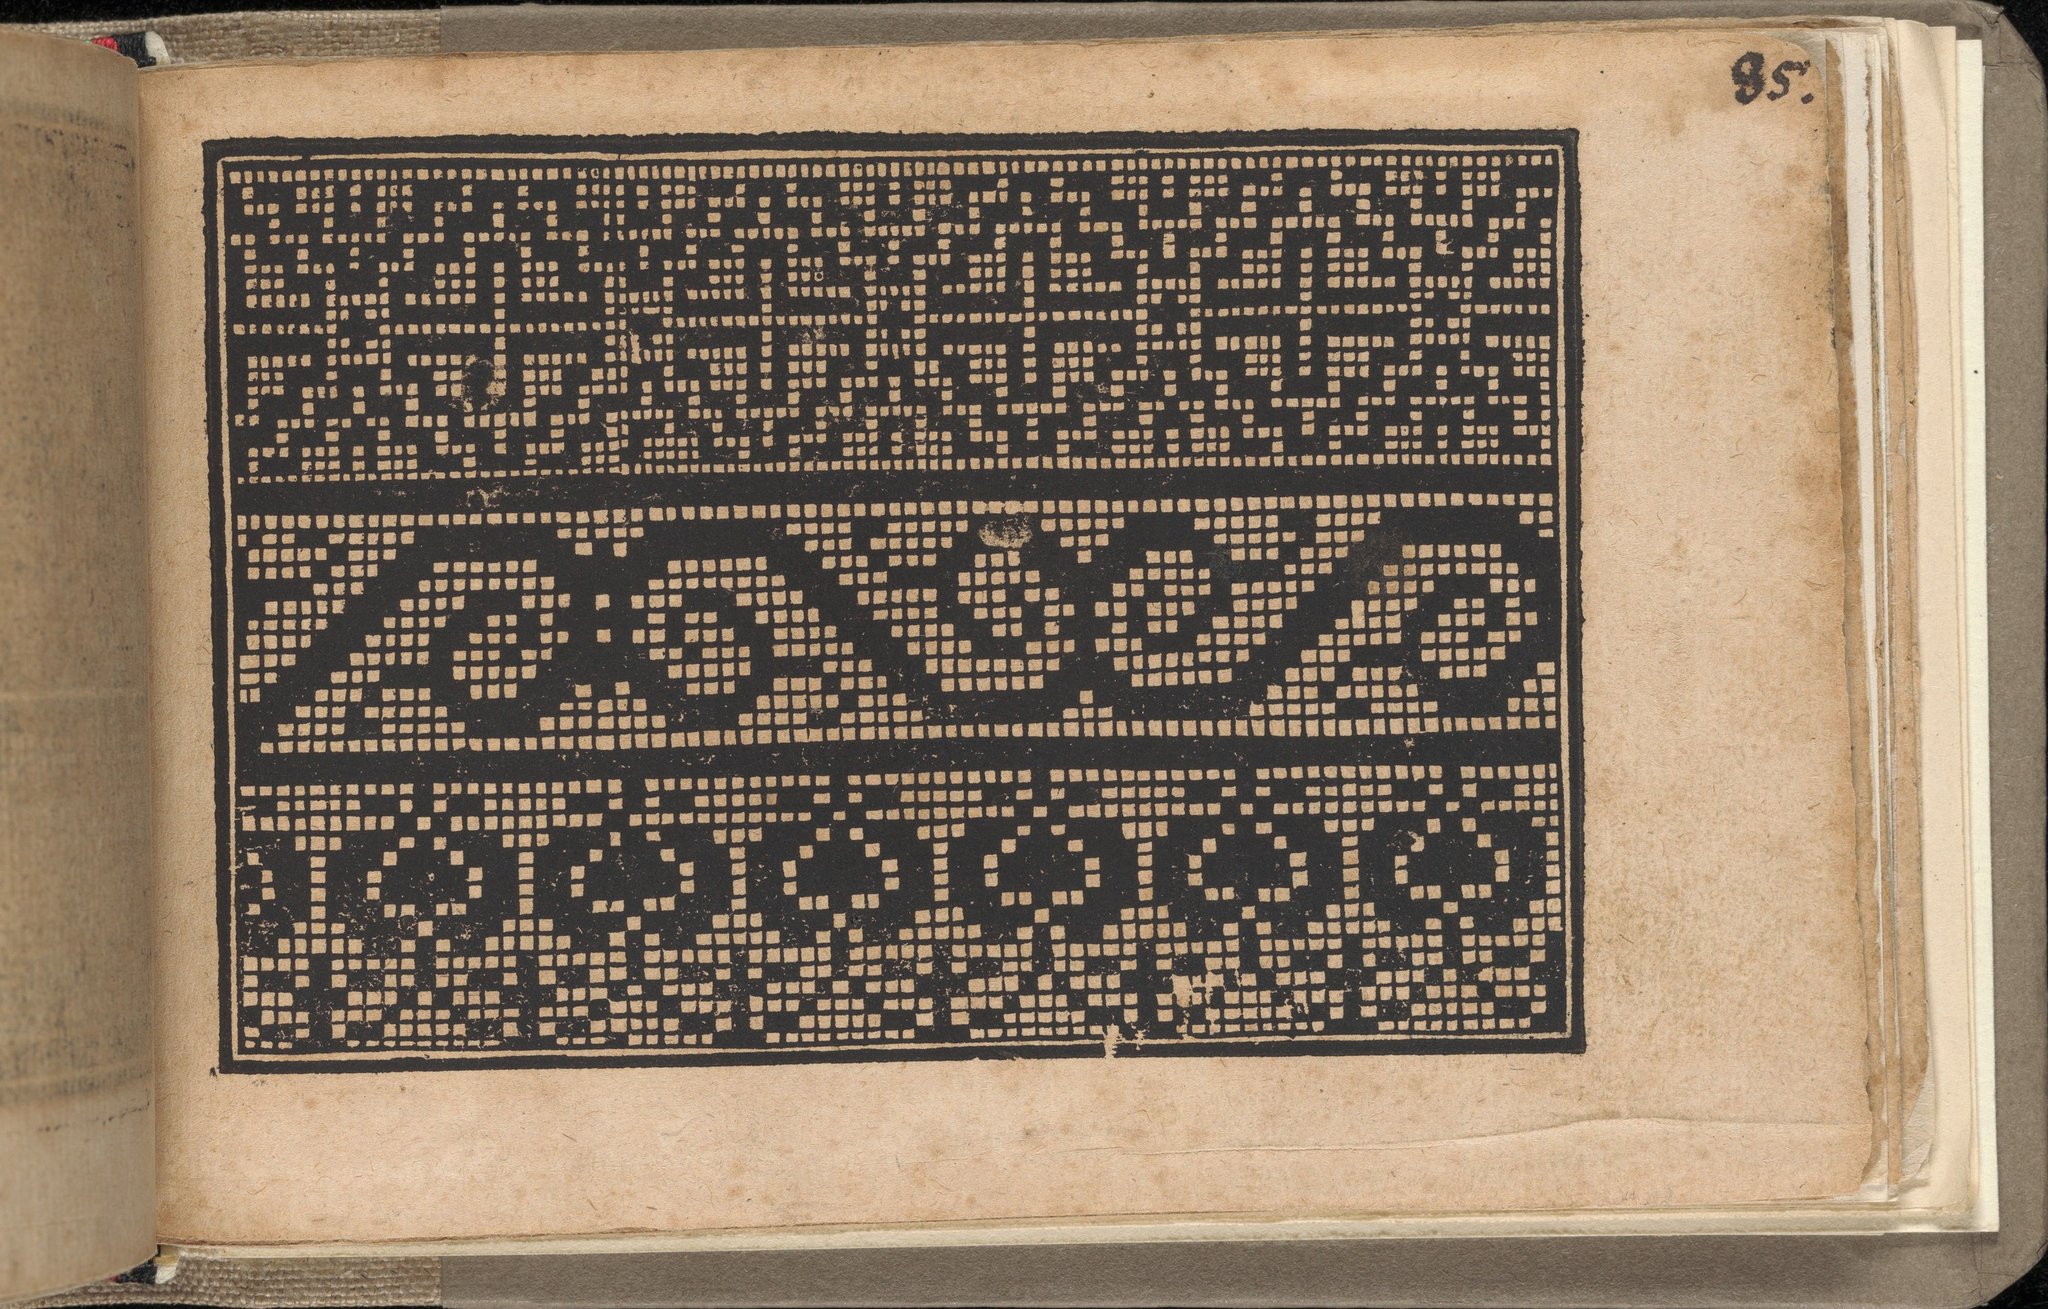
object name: book print ornament architecture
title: Schön newes Modelbuch (Page 85r)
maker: sigismundus latomus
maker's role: publisher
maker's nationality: german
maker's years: 1599-1632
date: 1608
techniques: woodcut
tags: flowers